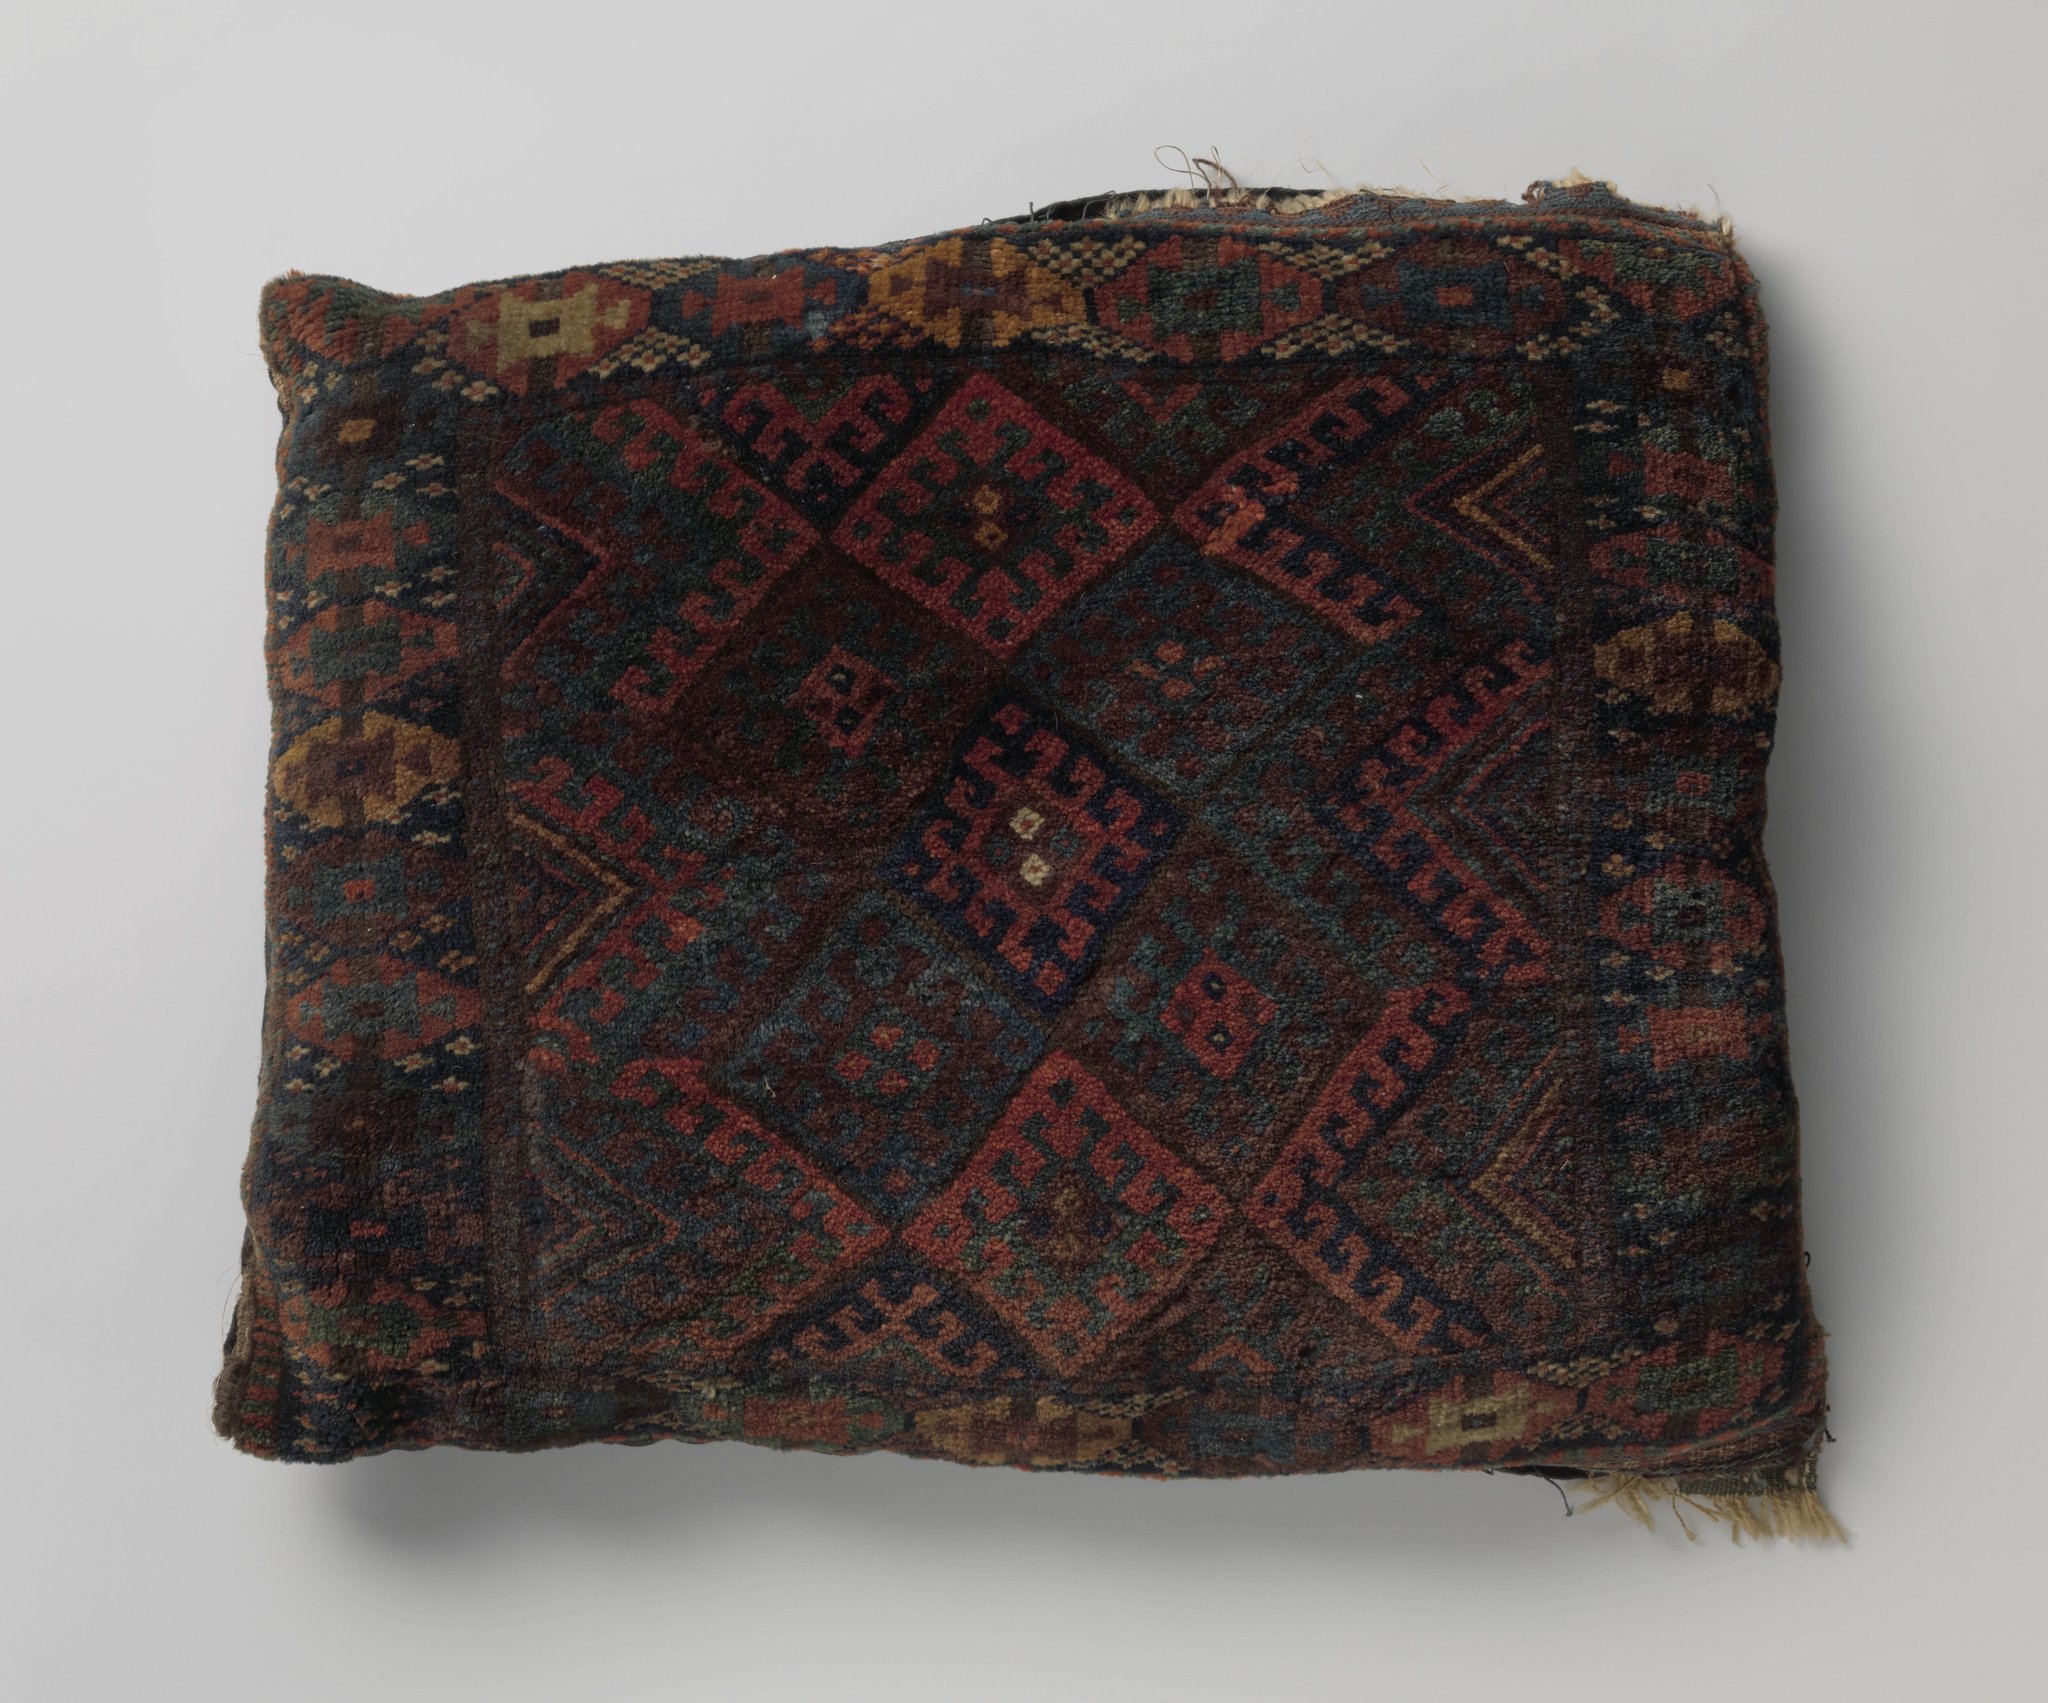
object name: fragment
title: Zadeltas, versierd met ruiten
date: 1800-1900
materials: wool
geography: kurdistan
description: Voorblad van een zadeltas, Jaffi-Kurdistan-Mosul, waarvan het middenveld versierd is met ruiten. De rand is versierd met ruiten en witte bloemen. Korte baard aan onder- en bovenzijde met witte bloemen.